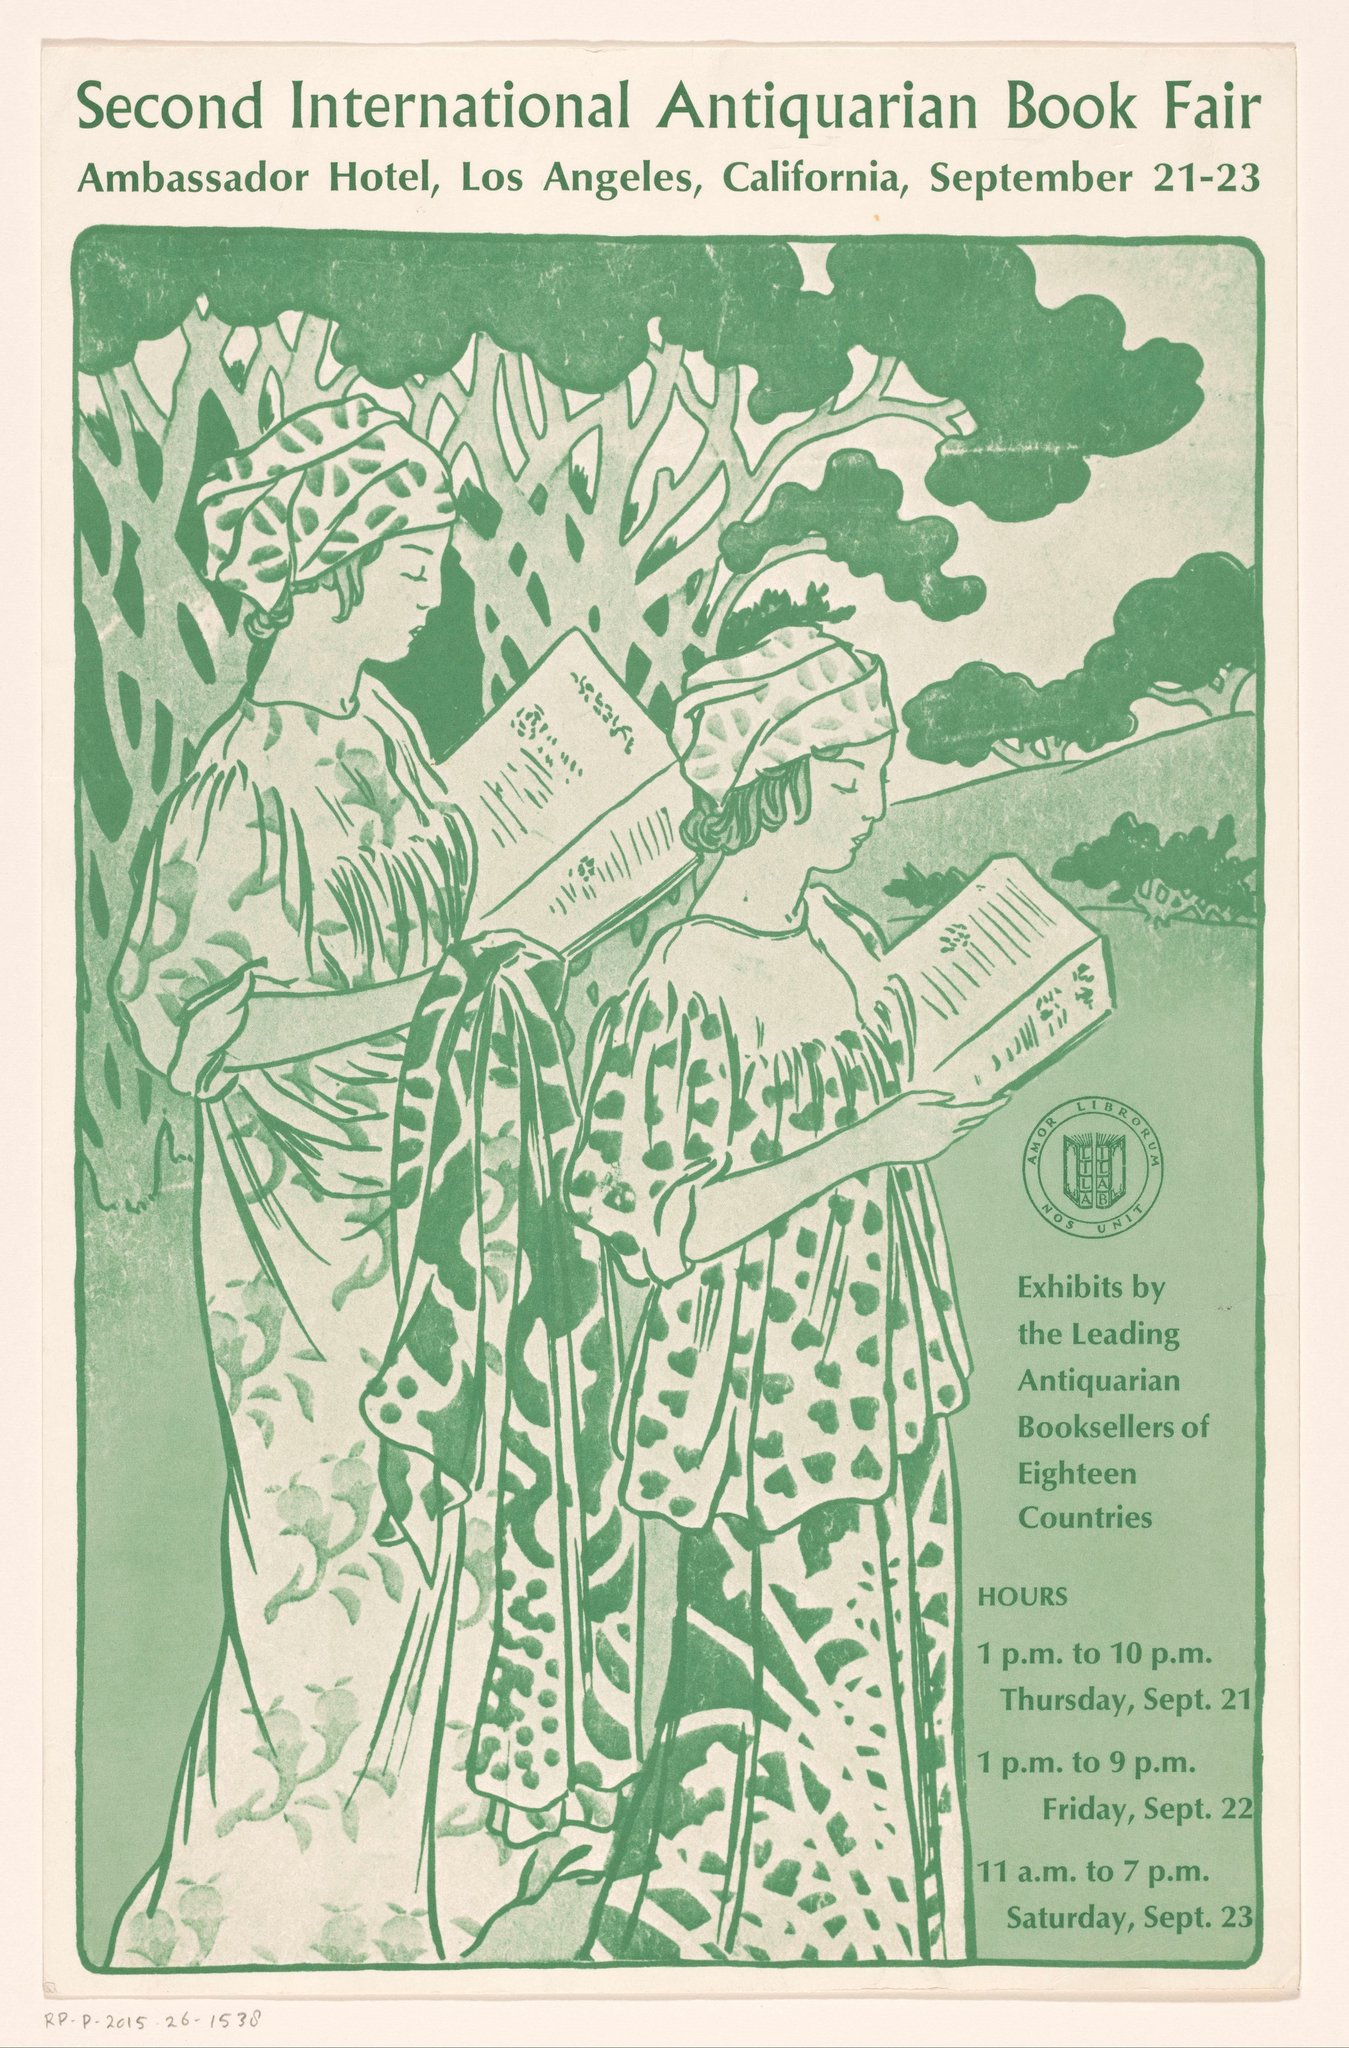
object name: reclamebiljet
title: Second International Antiquarian Book Fair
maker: Anonymous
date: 1967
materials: cardboard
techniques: offset printed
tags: reading, book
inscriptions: collector's mark: Lugt 2228